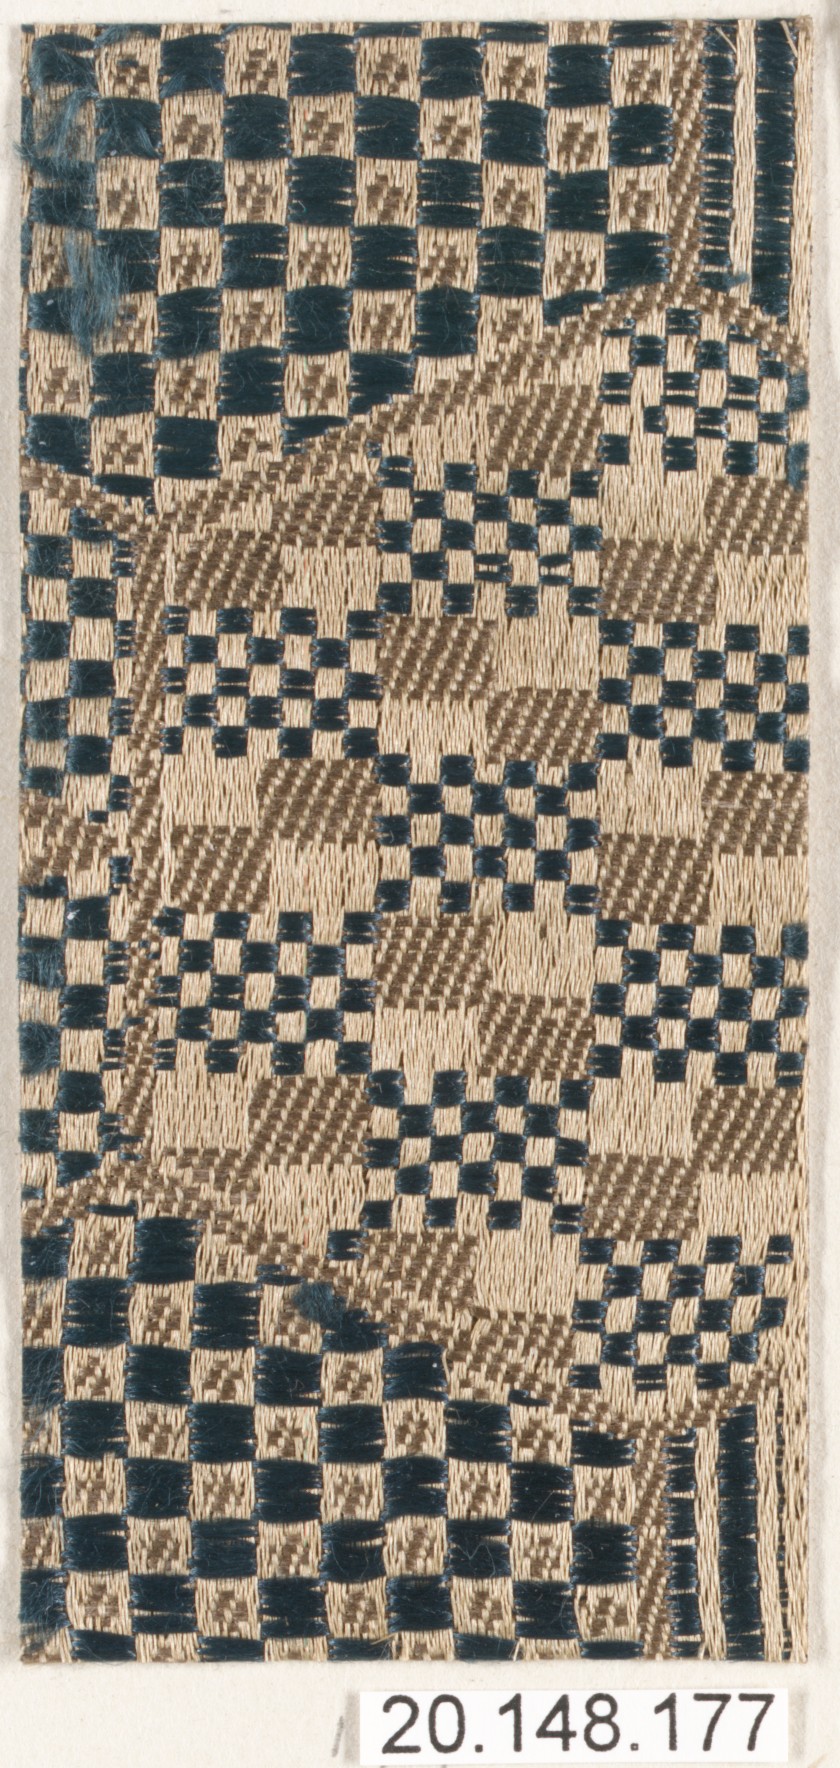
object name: piece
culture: japanese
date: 1701-1800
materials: silk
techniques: compound weave